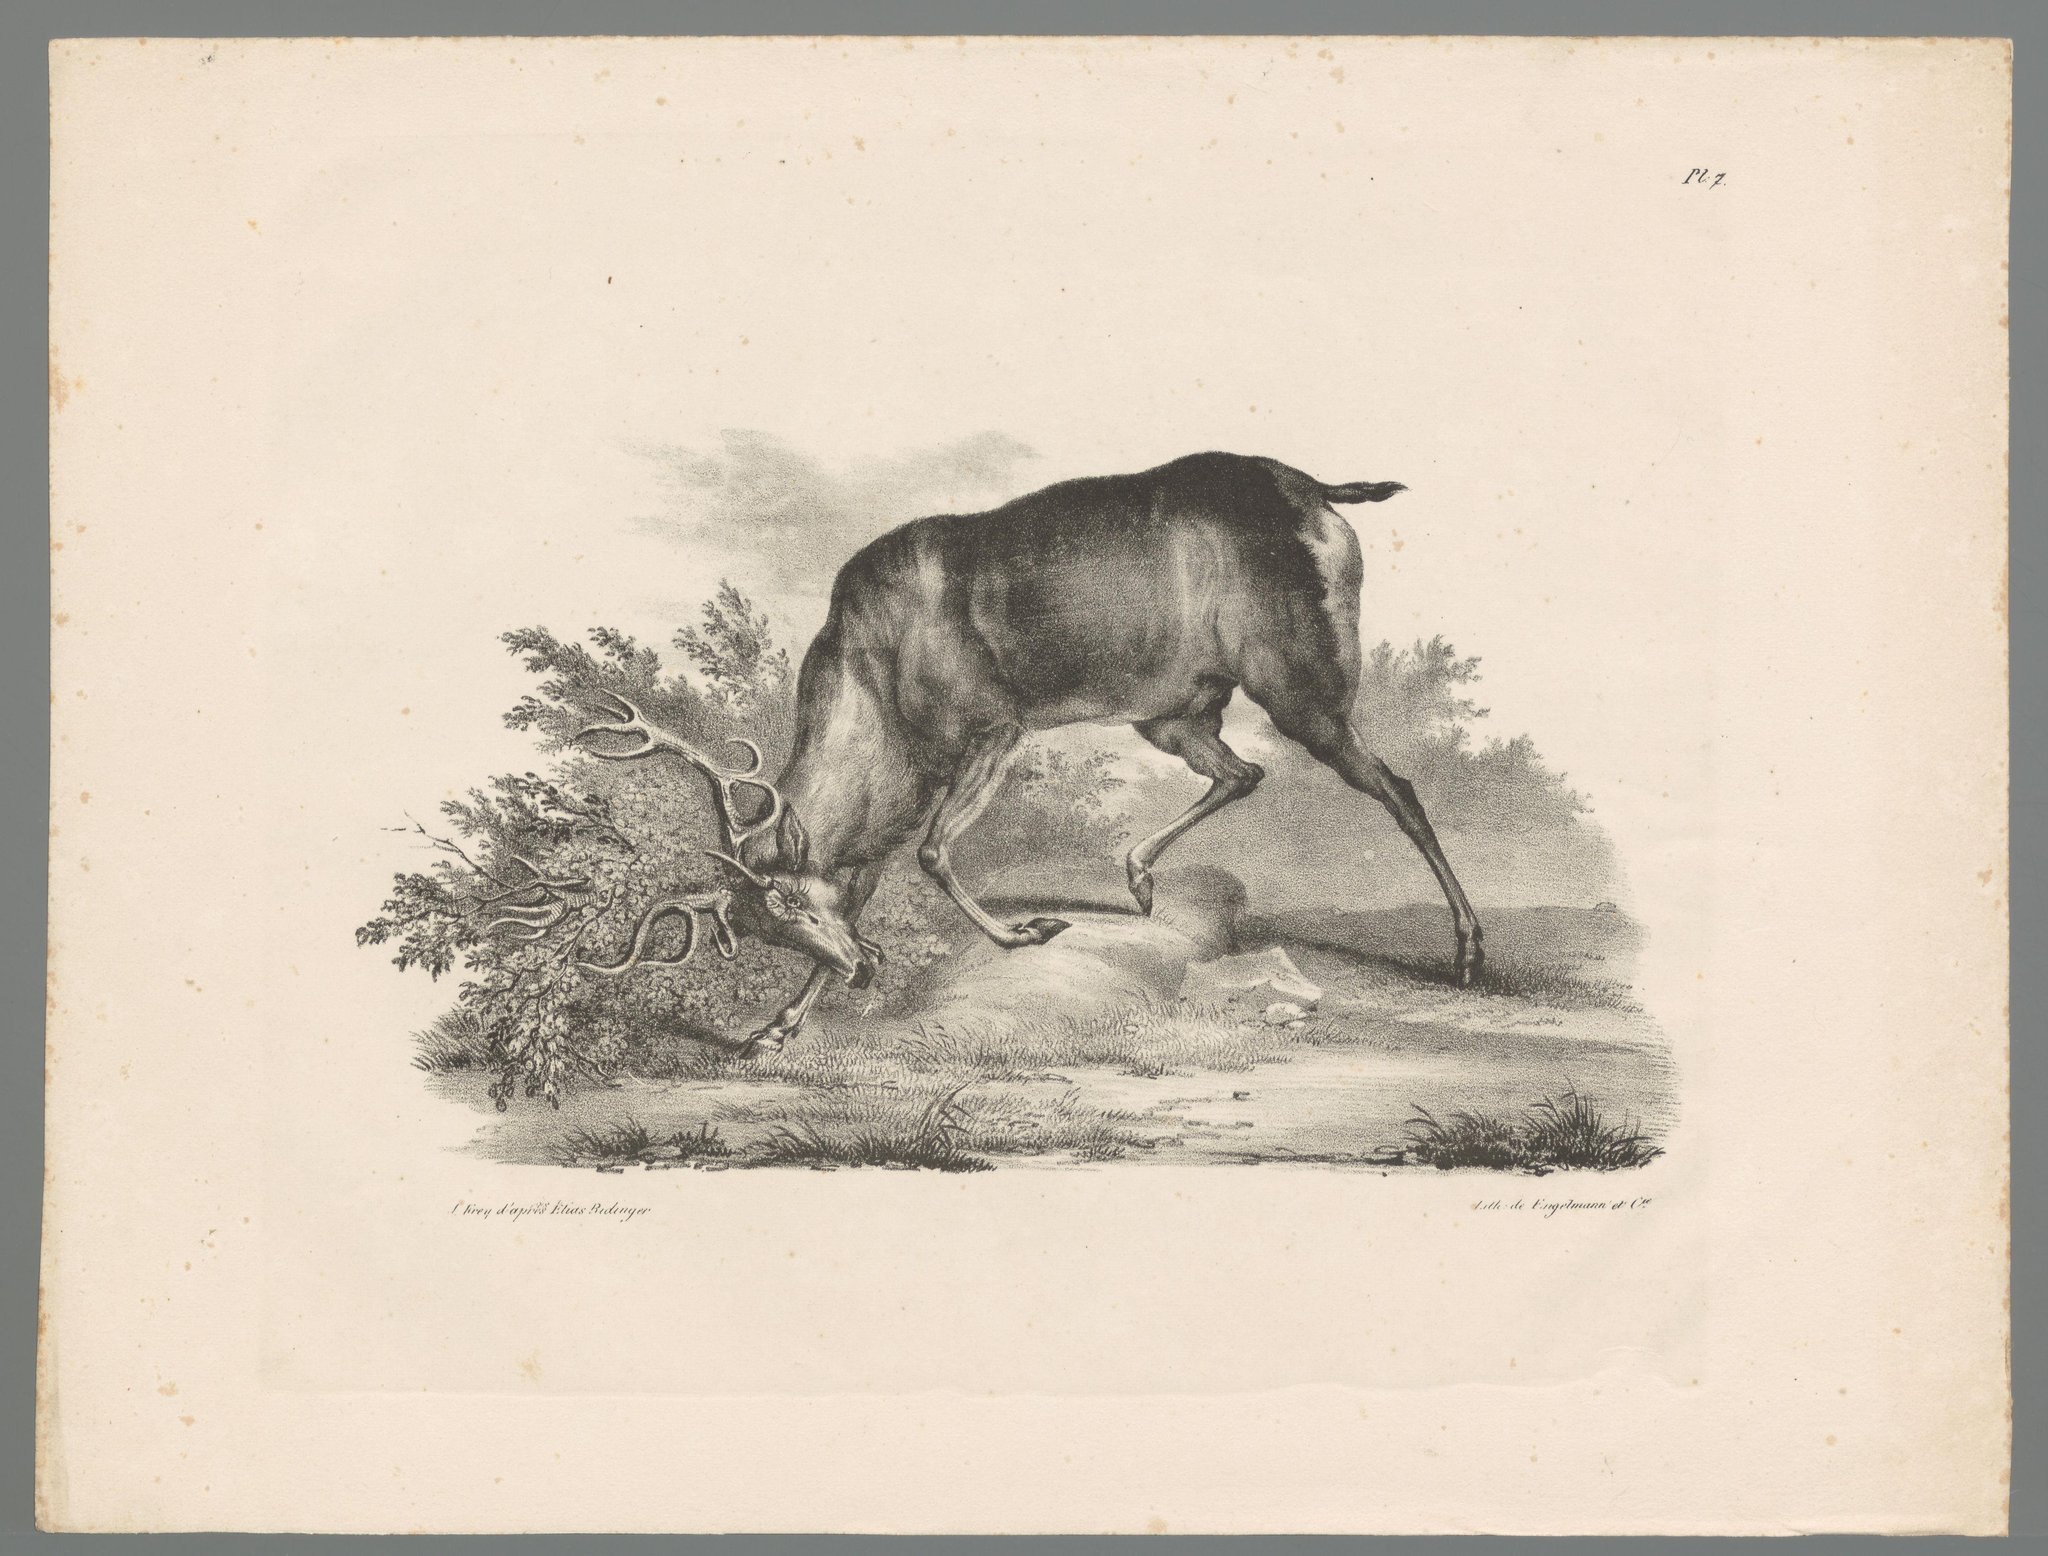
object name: print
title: Hert met gewei in een struik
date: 1825-1850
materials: paper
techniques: lithograph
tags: hoofed animals: deer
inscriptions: collector's mark: Lugt 2228